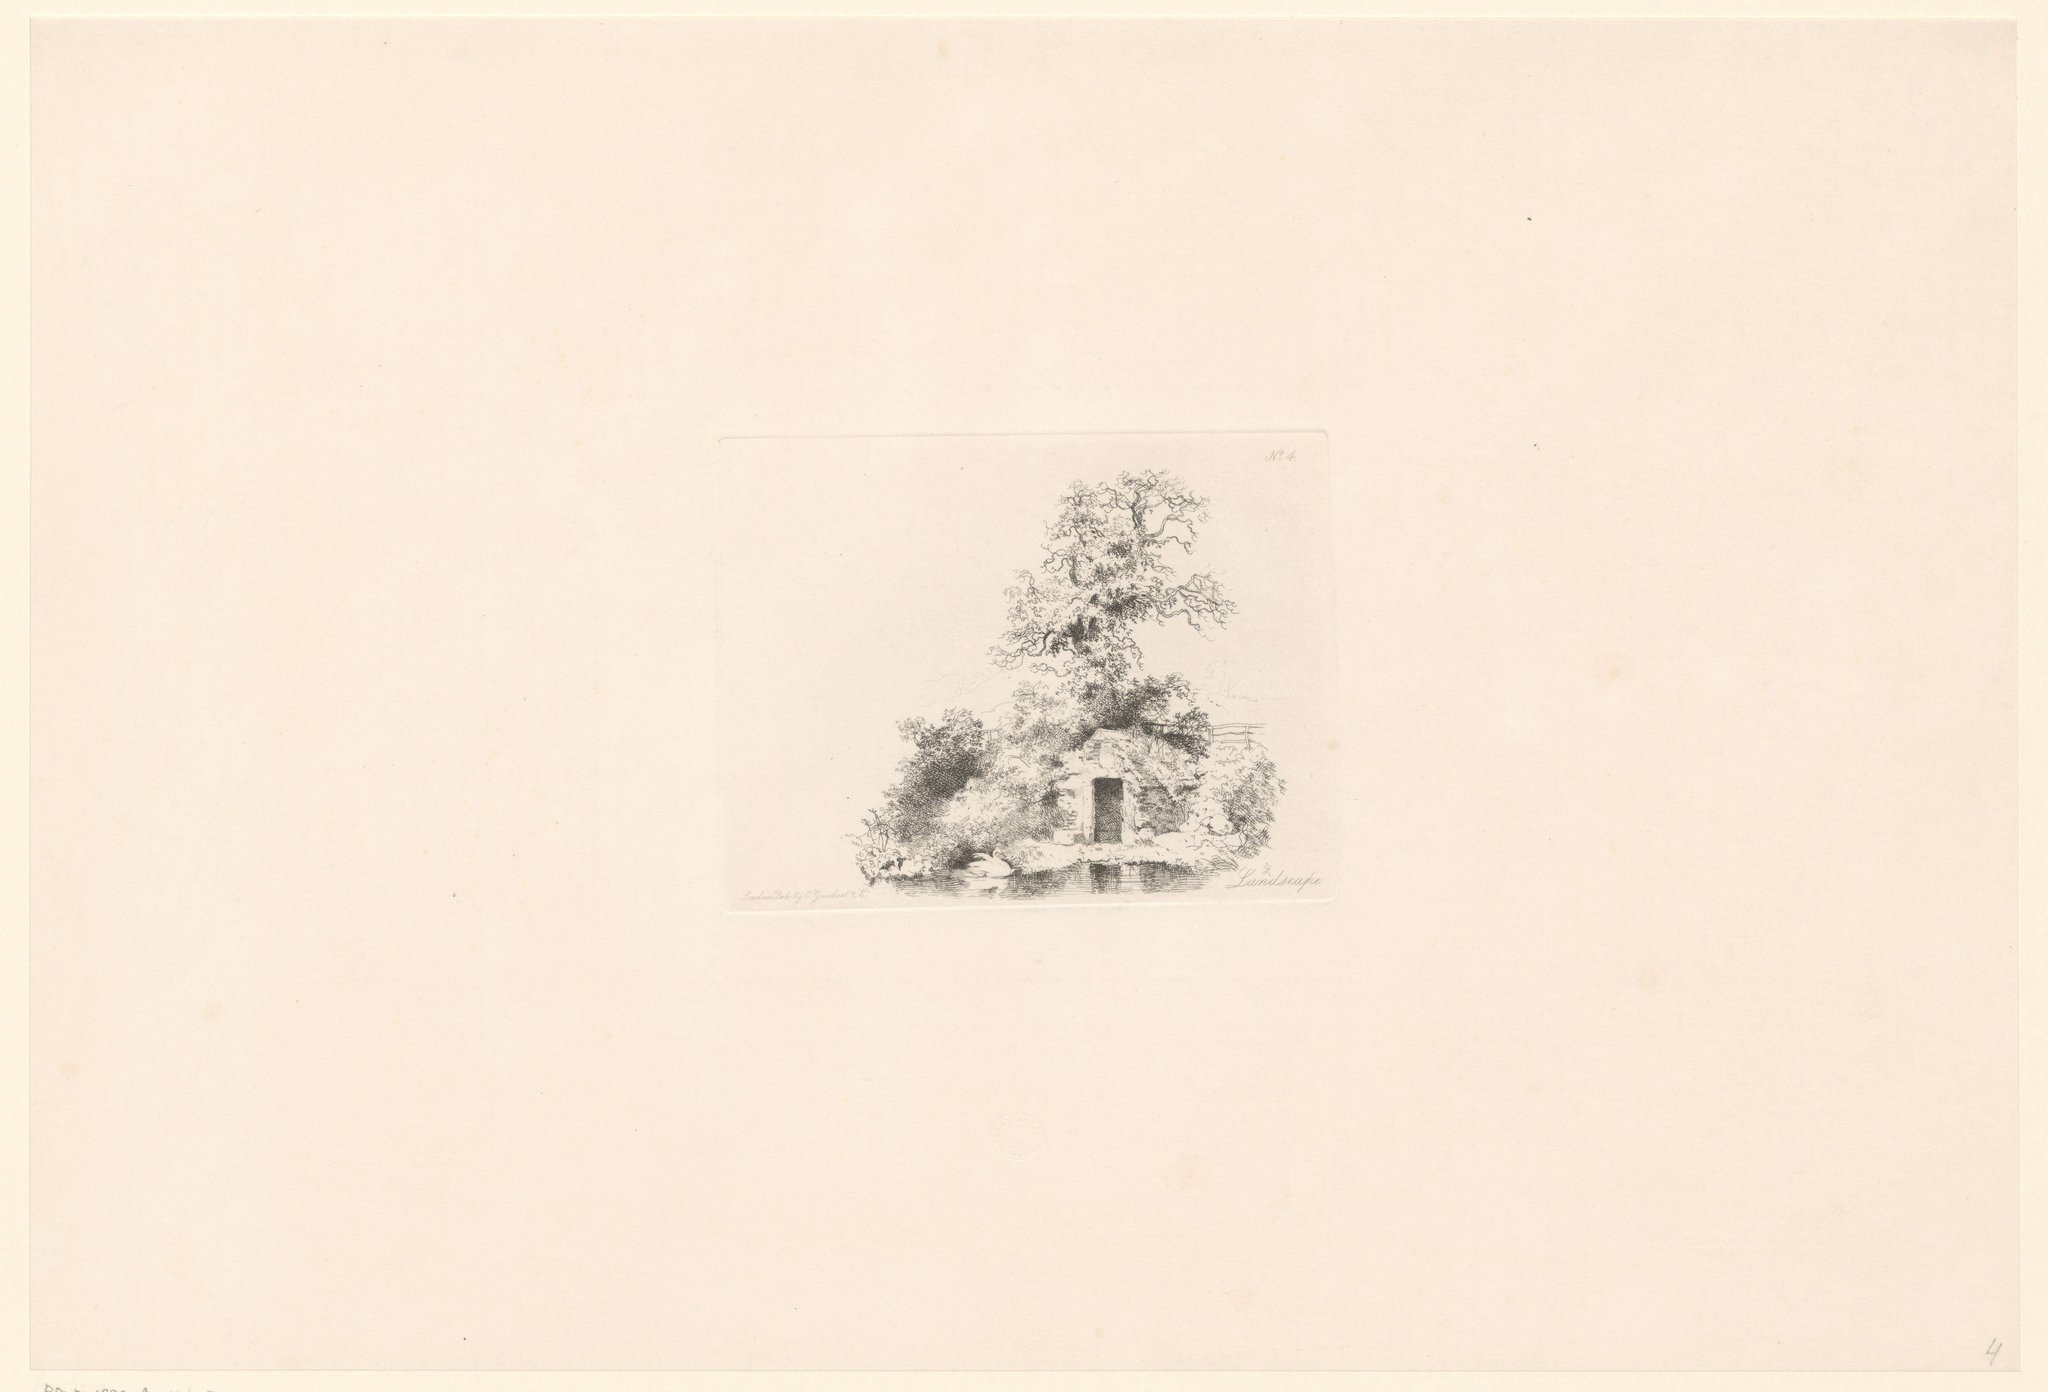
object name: print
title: Landschappen met jachthonden, wild en jagers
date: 1825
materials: paper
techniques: etching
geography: london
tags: water-birds: swan, cottage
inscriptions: collector's mark: Lugt 2228